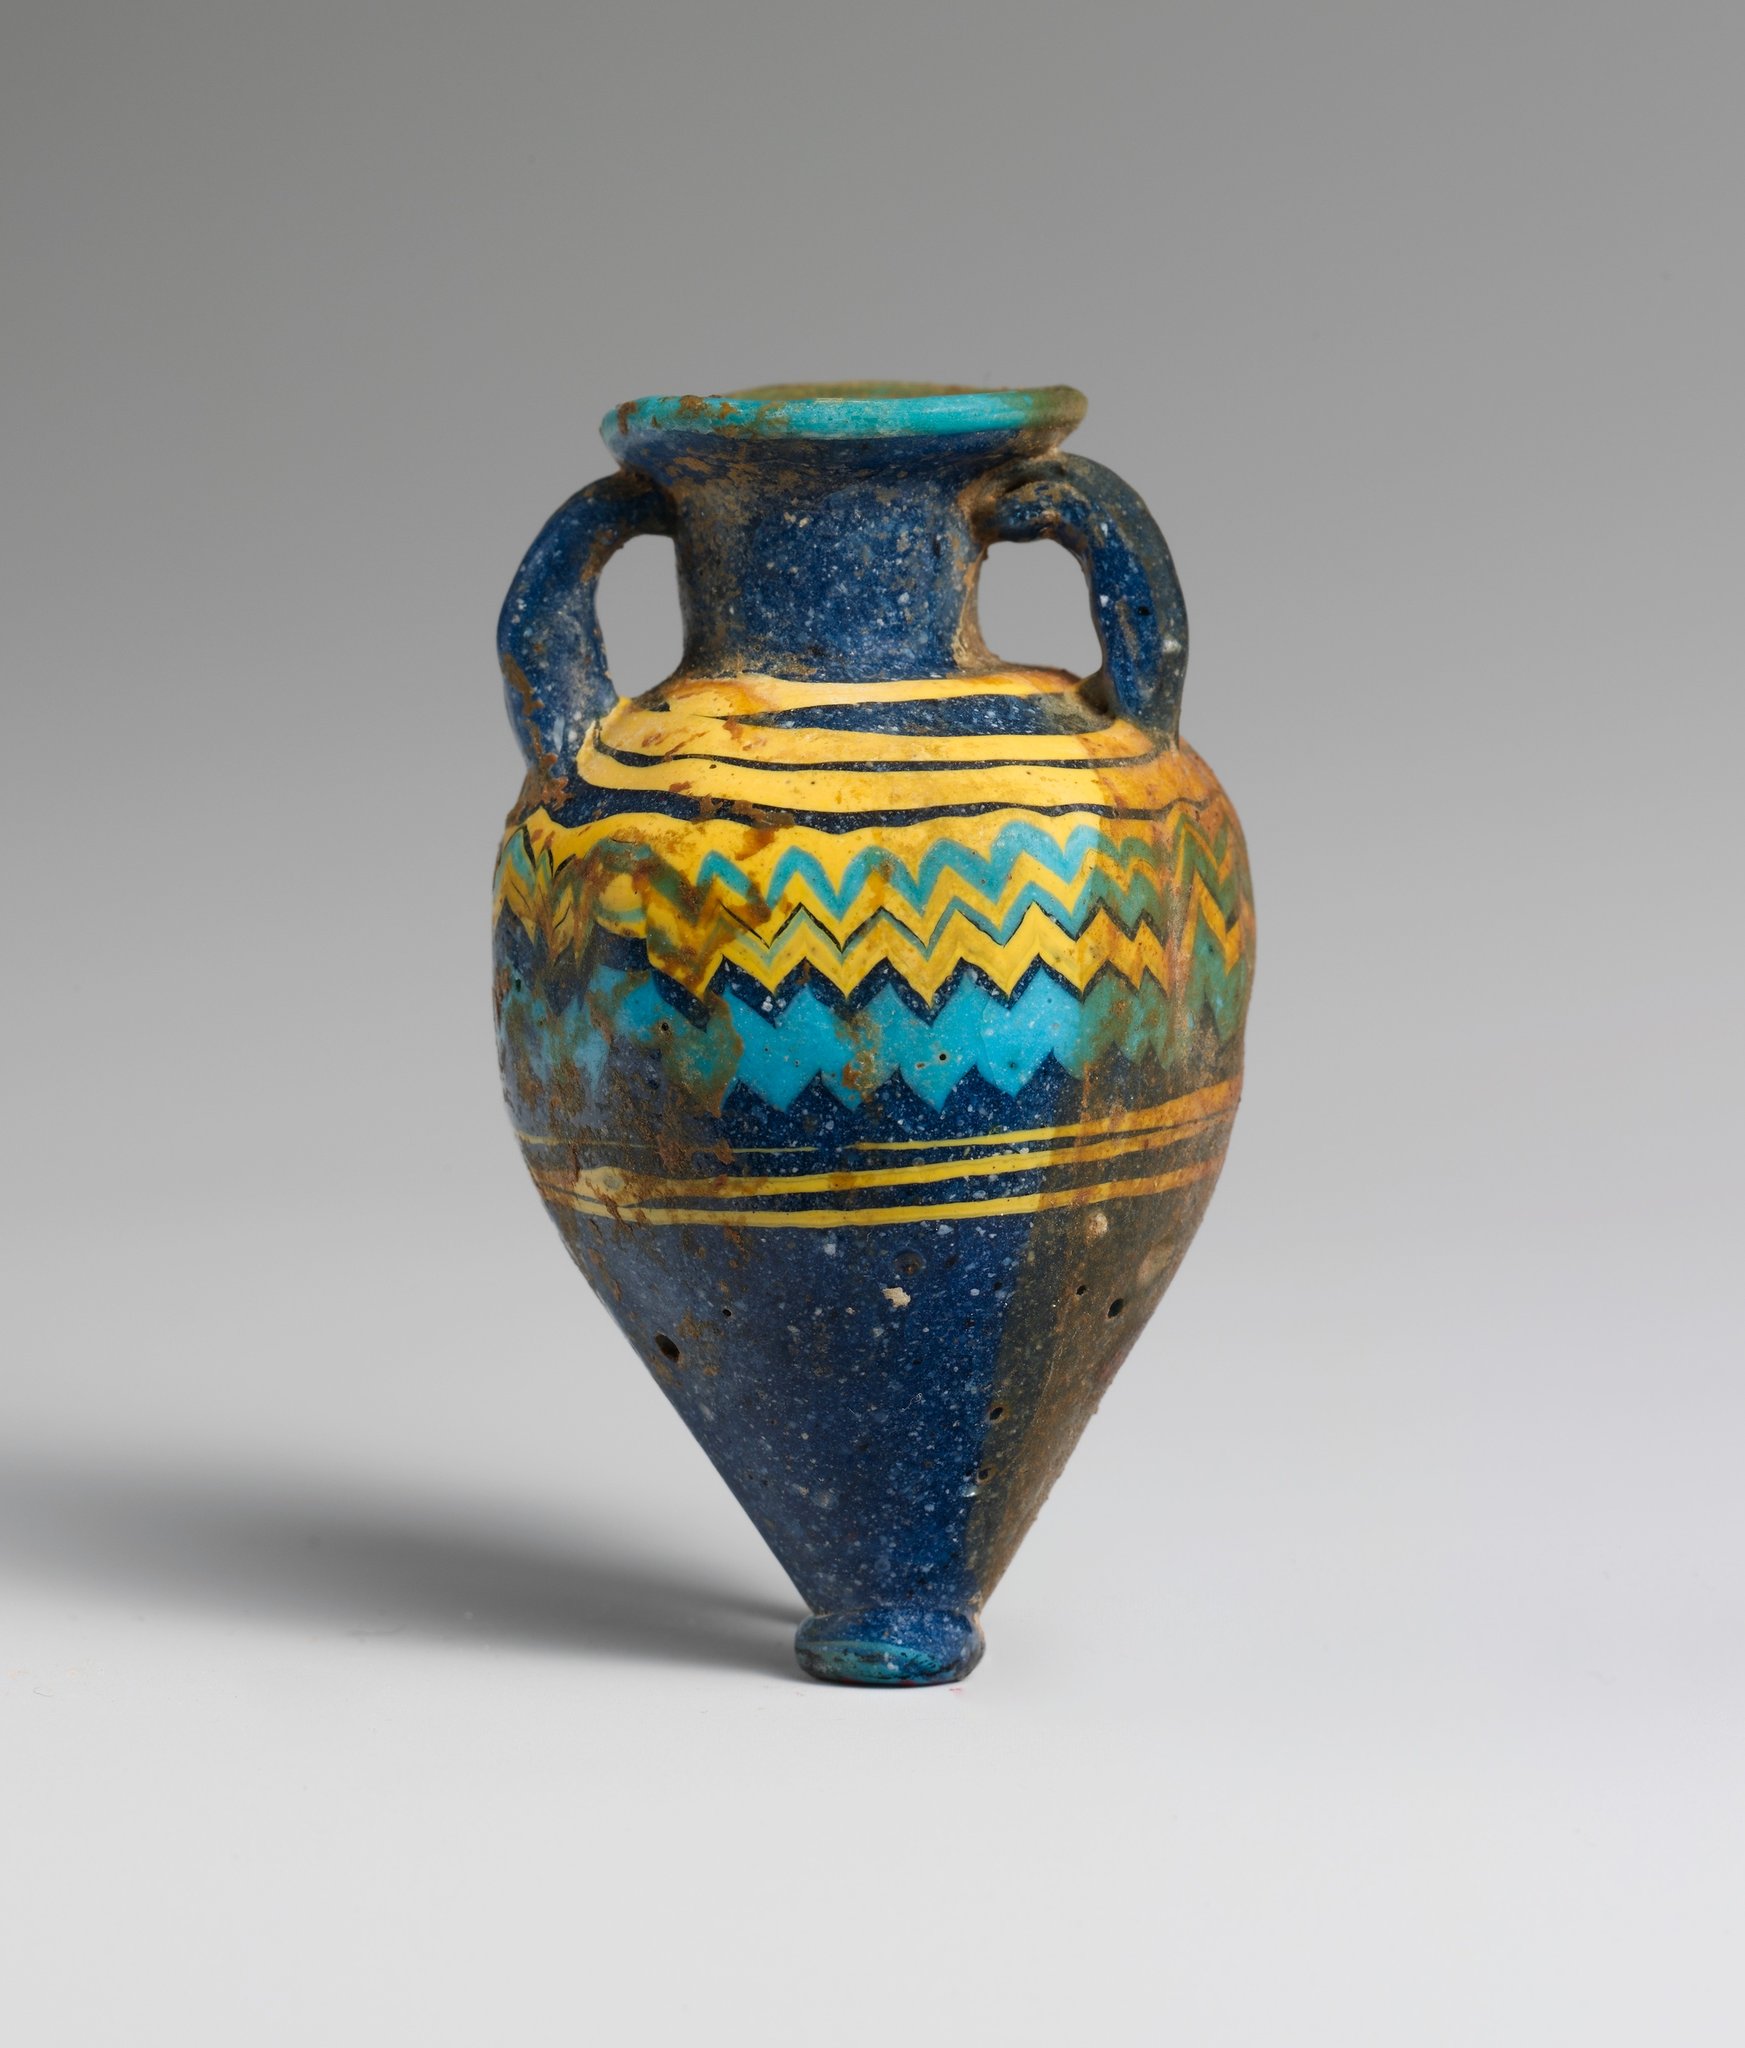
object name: amphoriskos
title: Glass amphoriskos (perfume bottle)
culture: greek, eastern mediterranean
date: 534-401 BCE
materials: glass